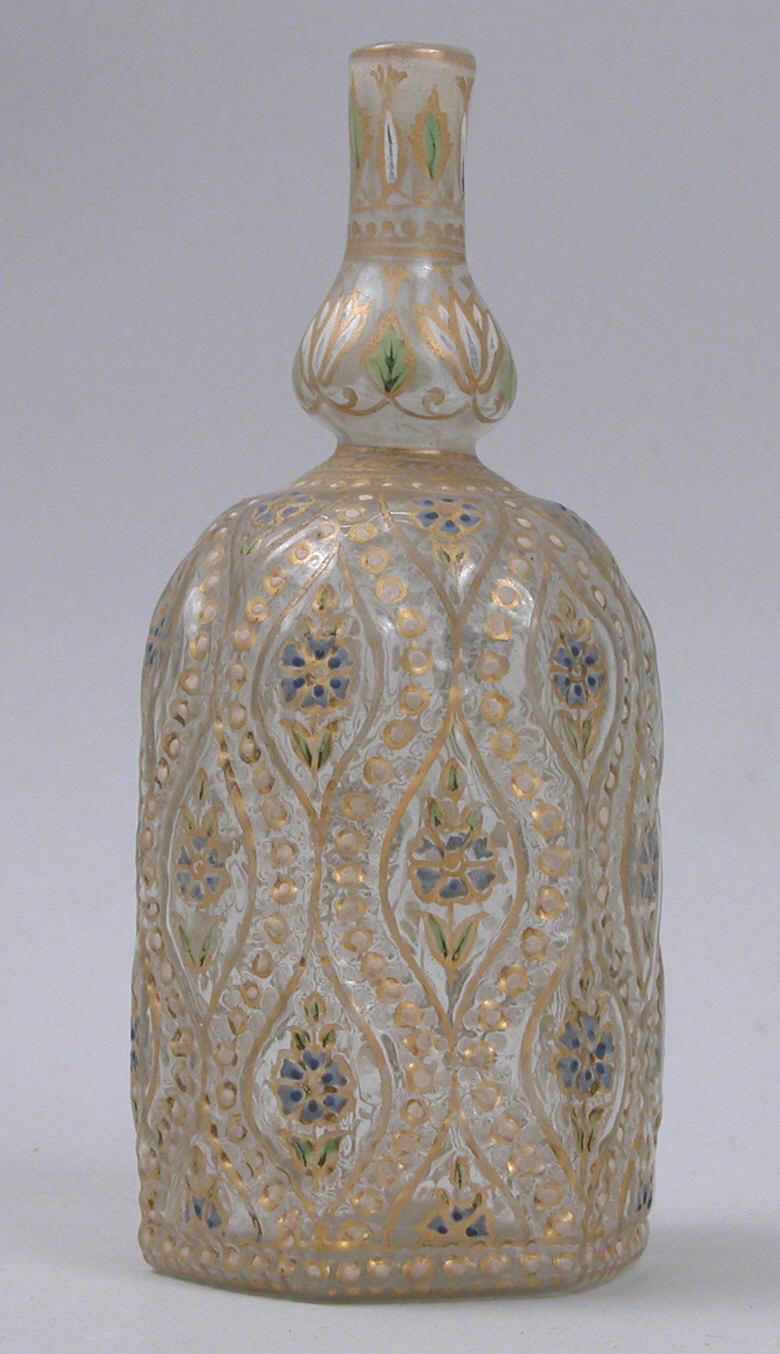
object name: perfume sprinkler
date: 1701-1800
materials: glass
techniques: glassblowing, enamel, gilding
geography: northern india